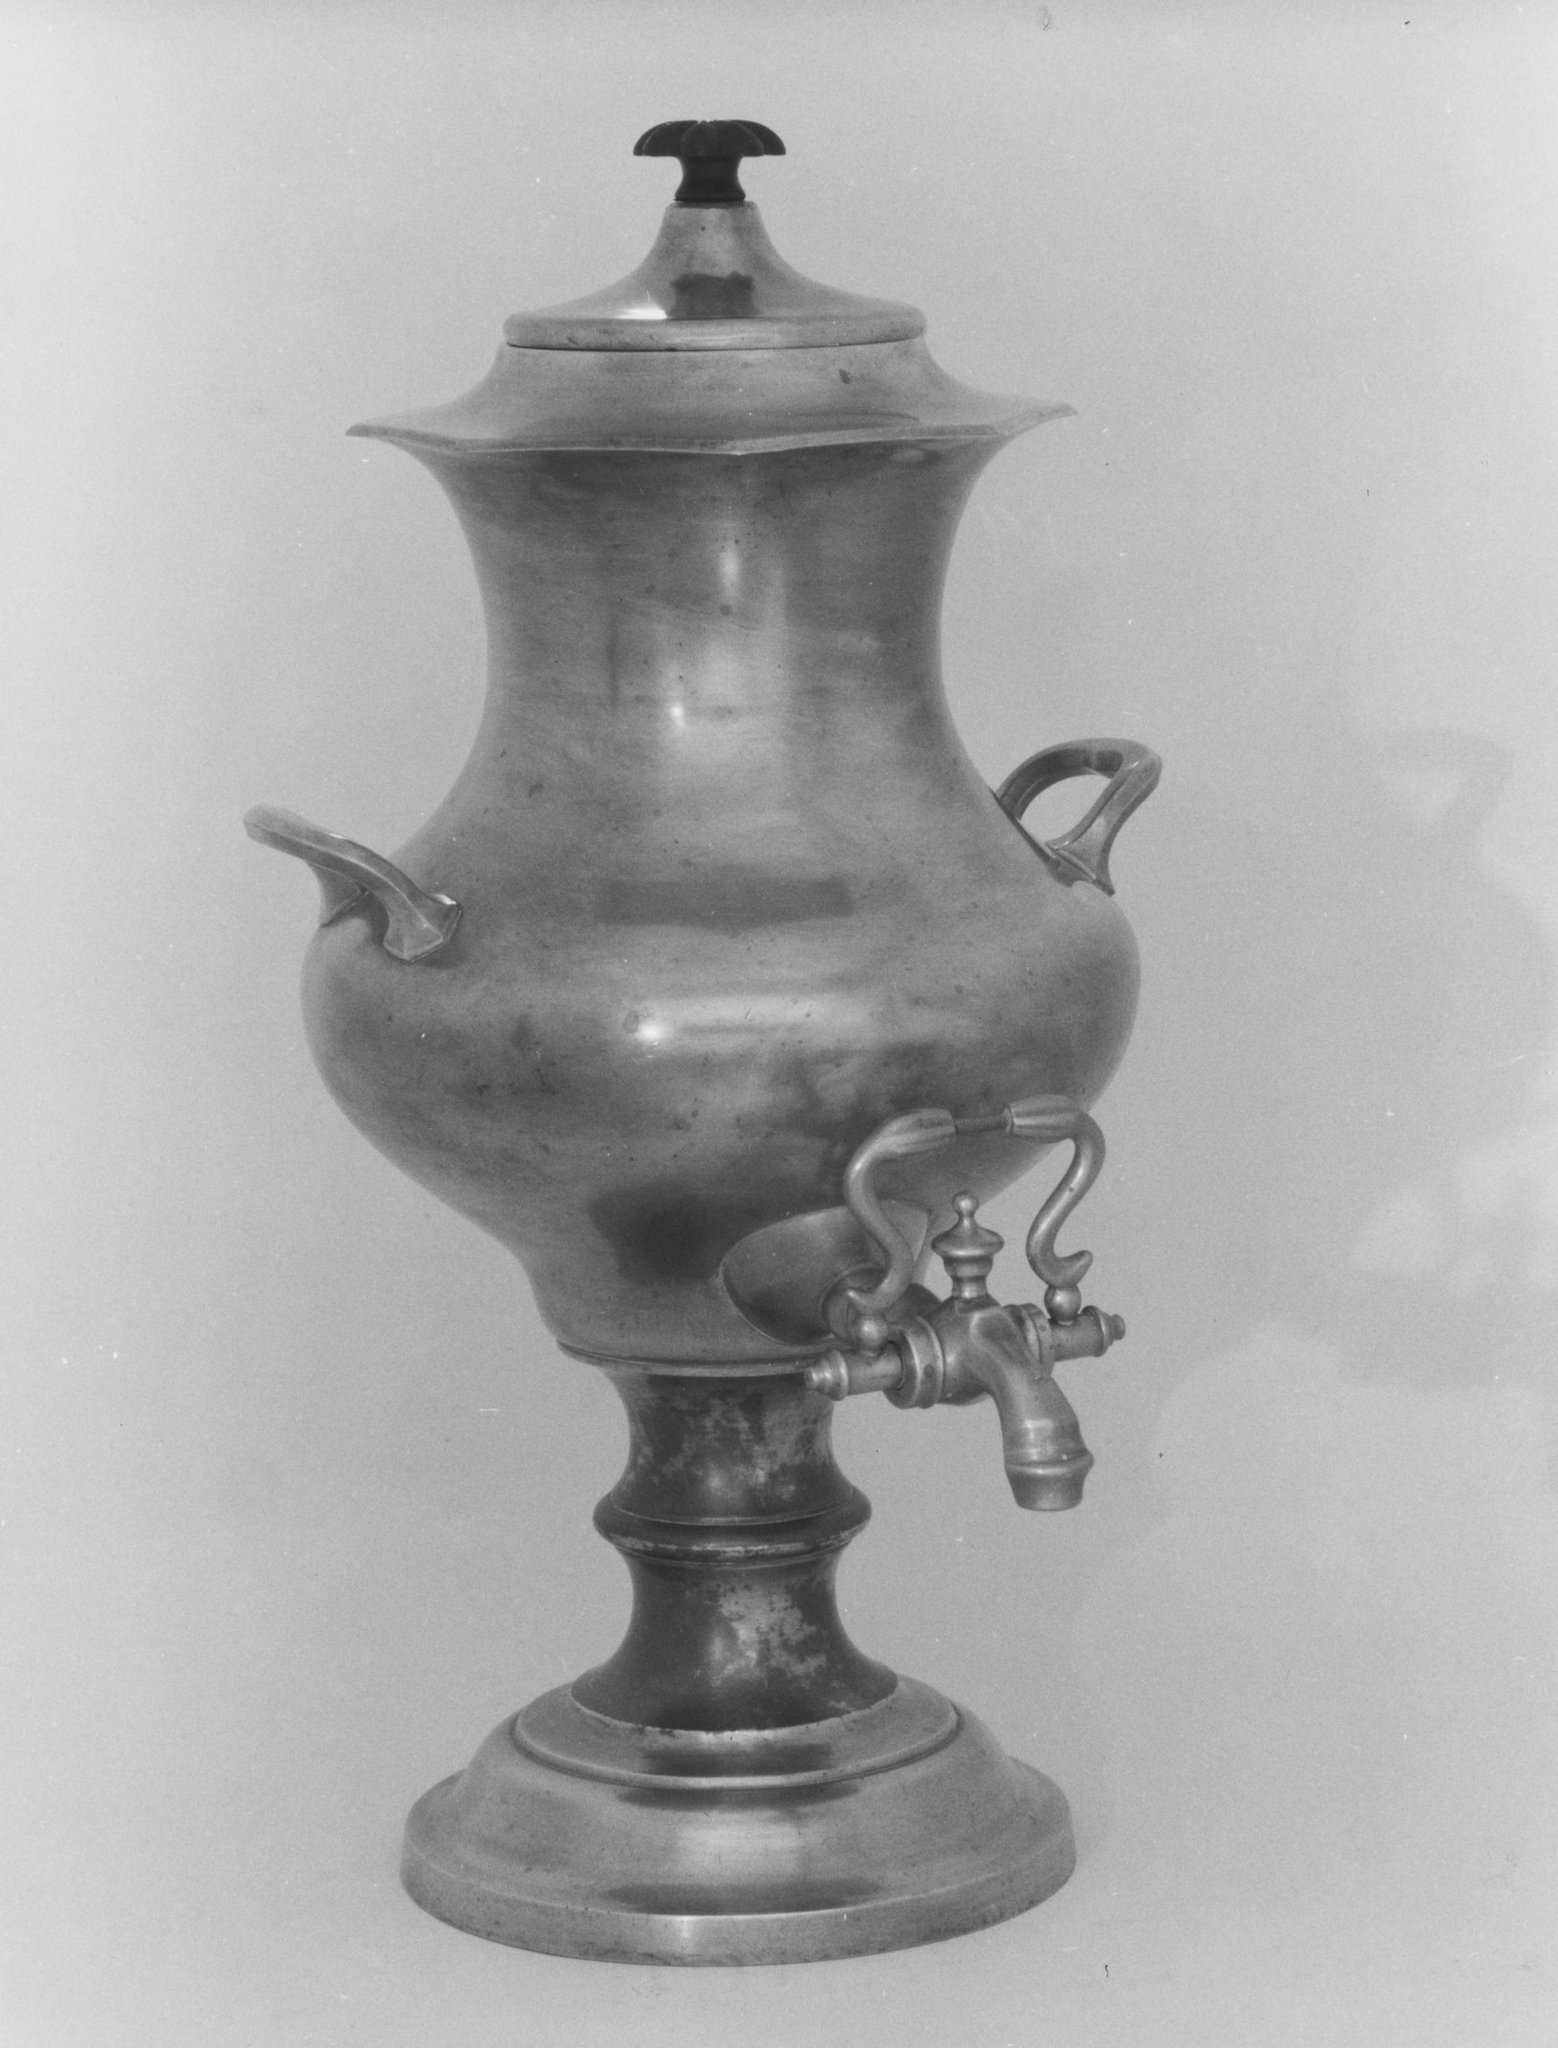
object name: coffee urn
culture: american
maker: roswell gleason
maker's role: maker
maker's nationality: american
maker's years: 1799-1887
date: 1840-1865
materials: brass, pewter, wood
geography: united states